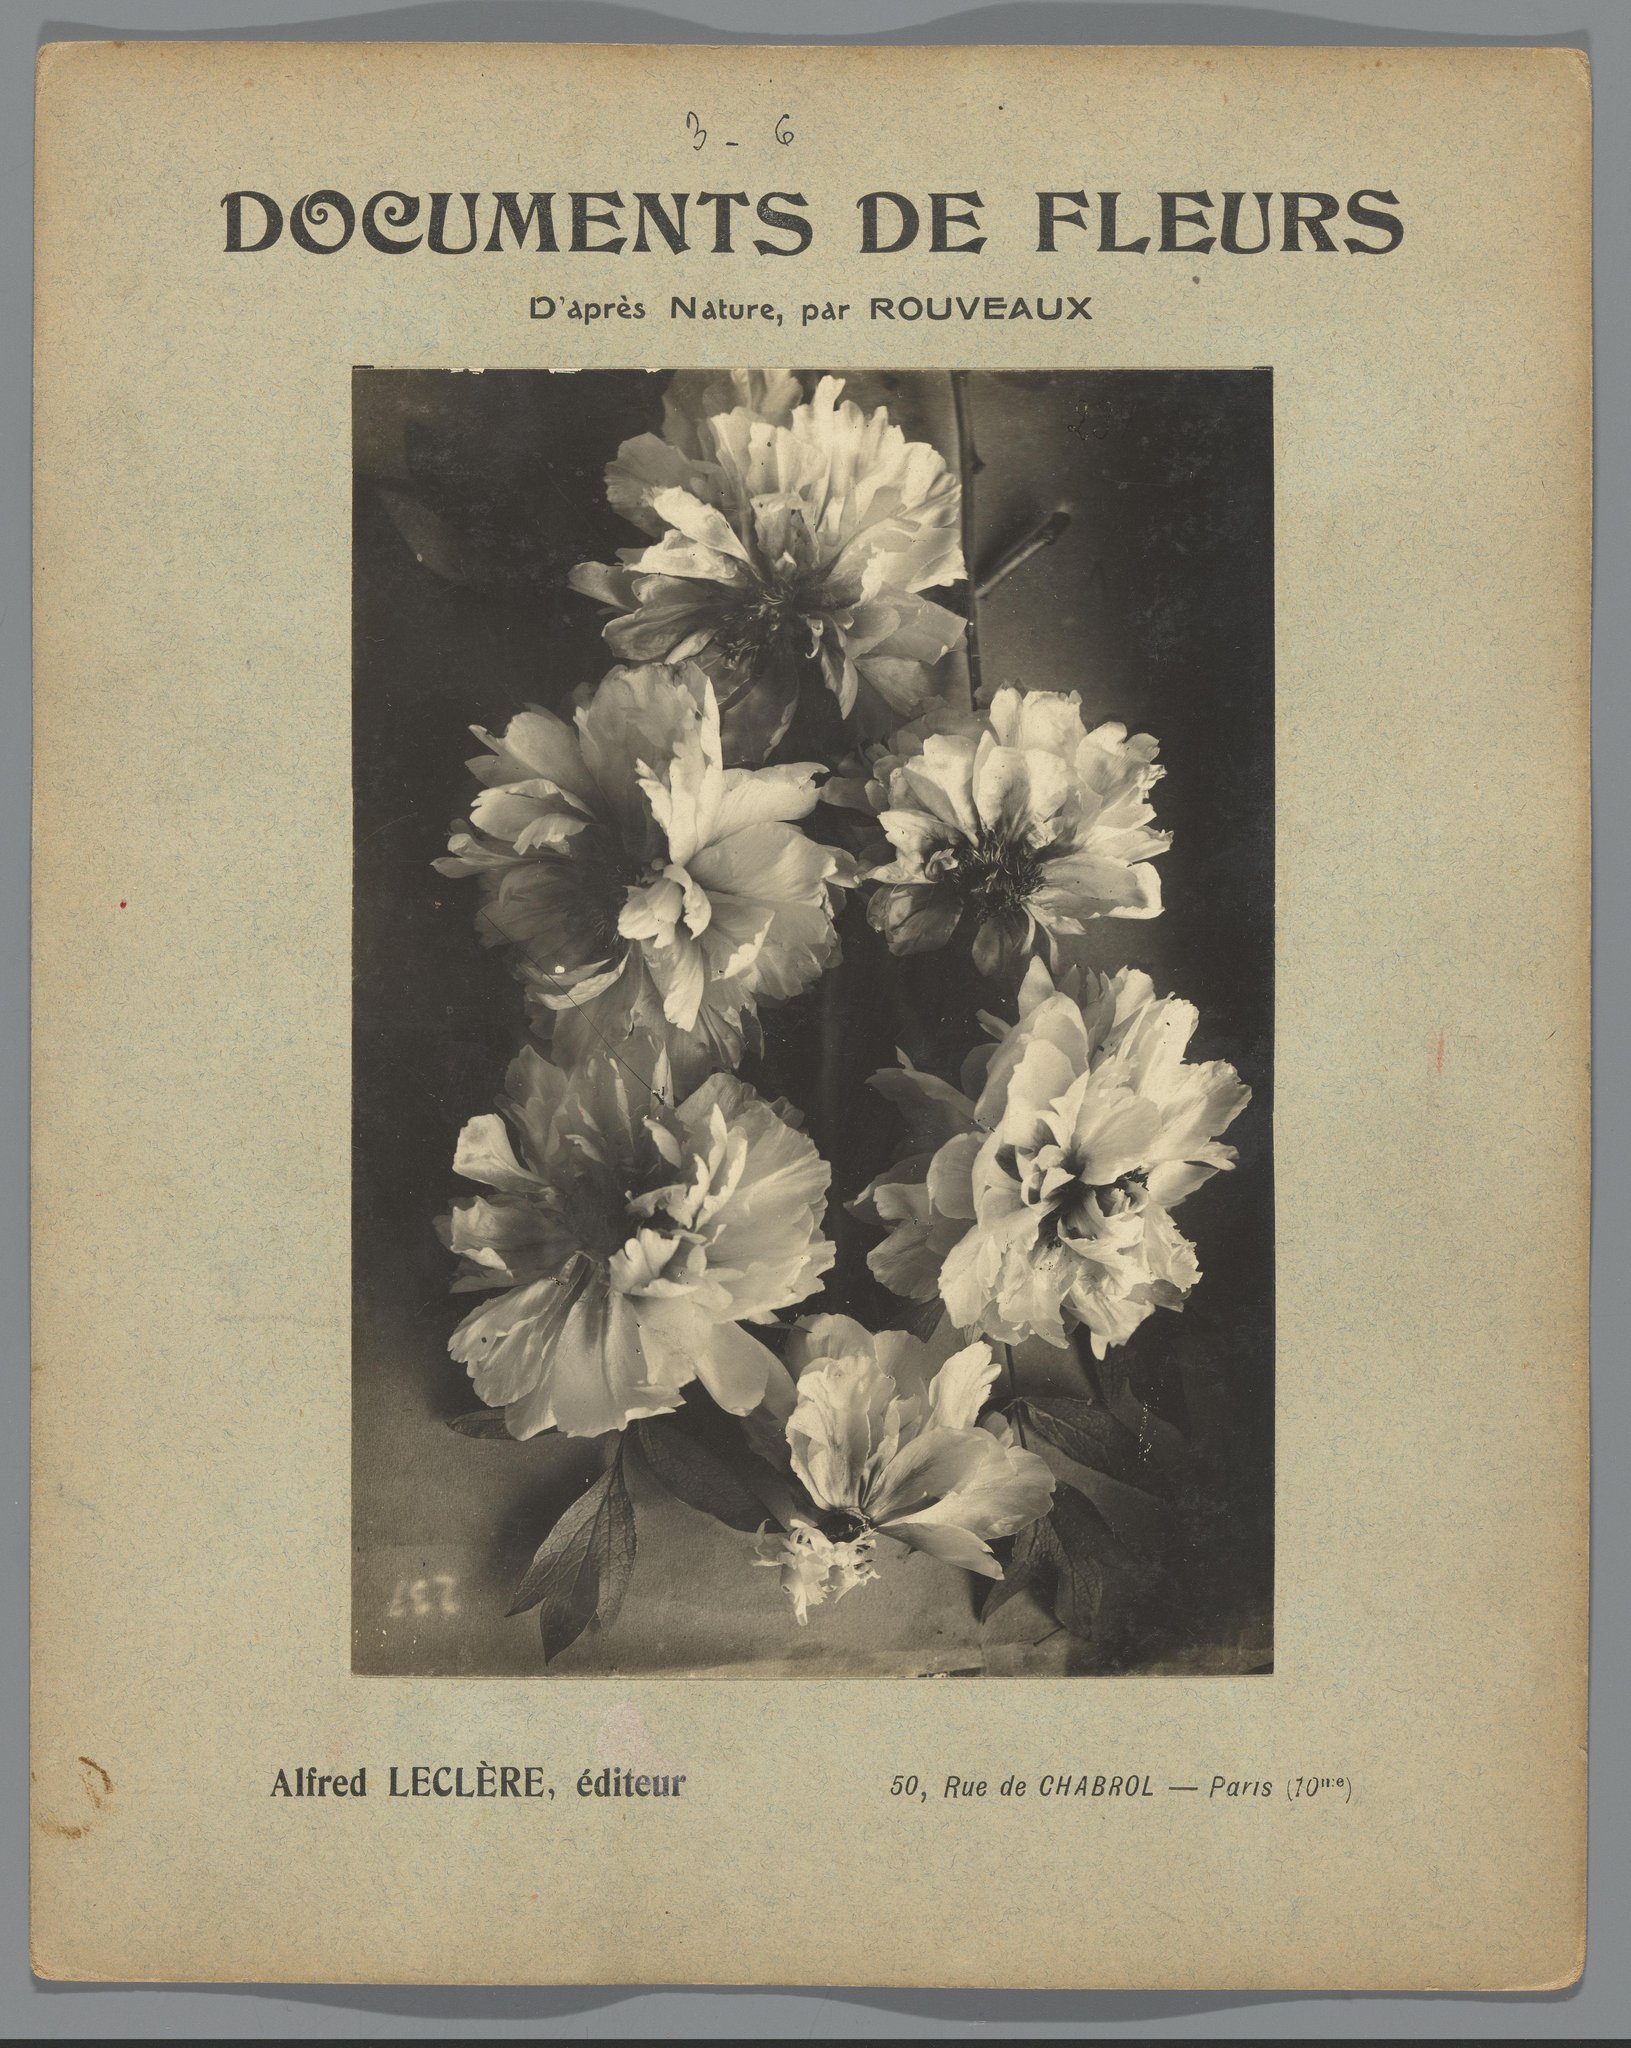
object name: photograph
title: Bloemstudie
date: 1895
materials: photographic support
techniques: gelatin silver print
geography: france